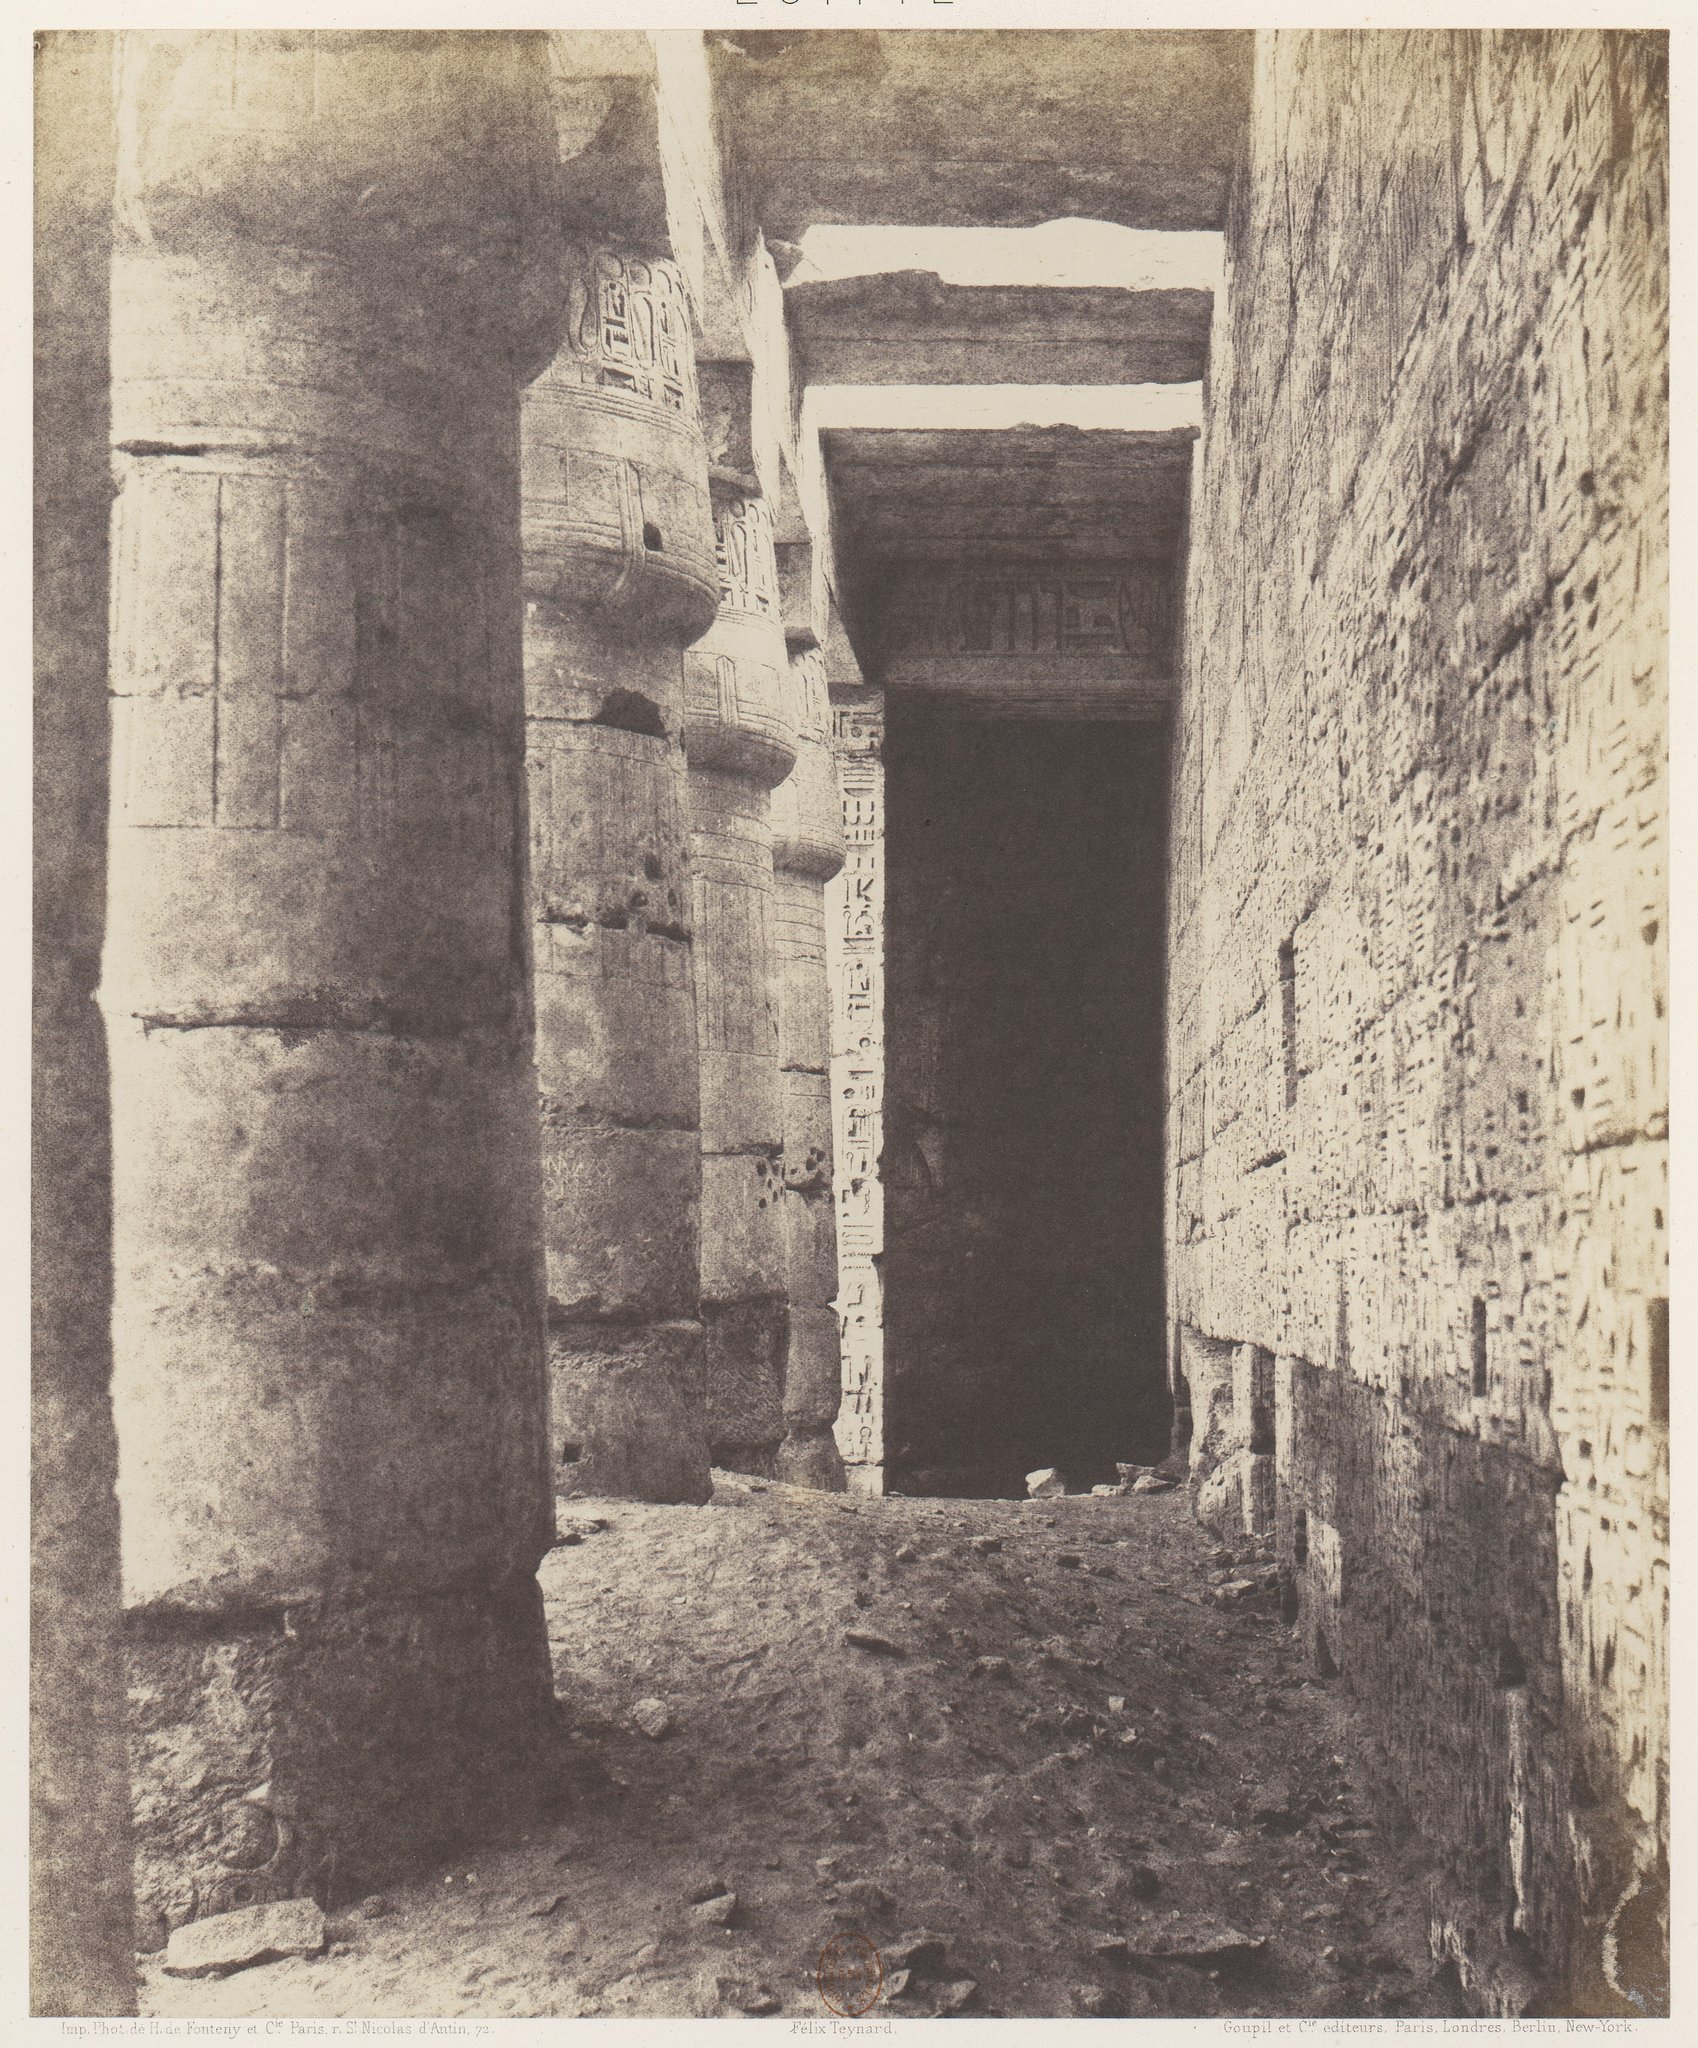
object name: photograph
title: Médînet-Abou (Thèbes), Construction Postérieures - Deuxiéme Cour - Galerie Sud-Ouest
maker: félix teynard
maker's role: artist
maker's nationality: french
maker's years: 1817-1892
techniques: paper negative, salted paper print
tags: architecture,columns